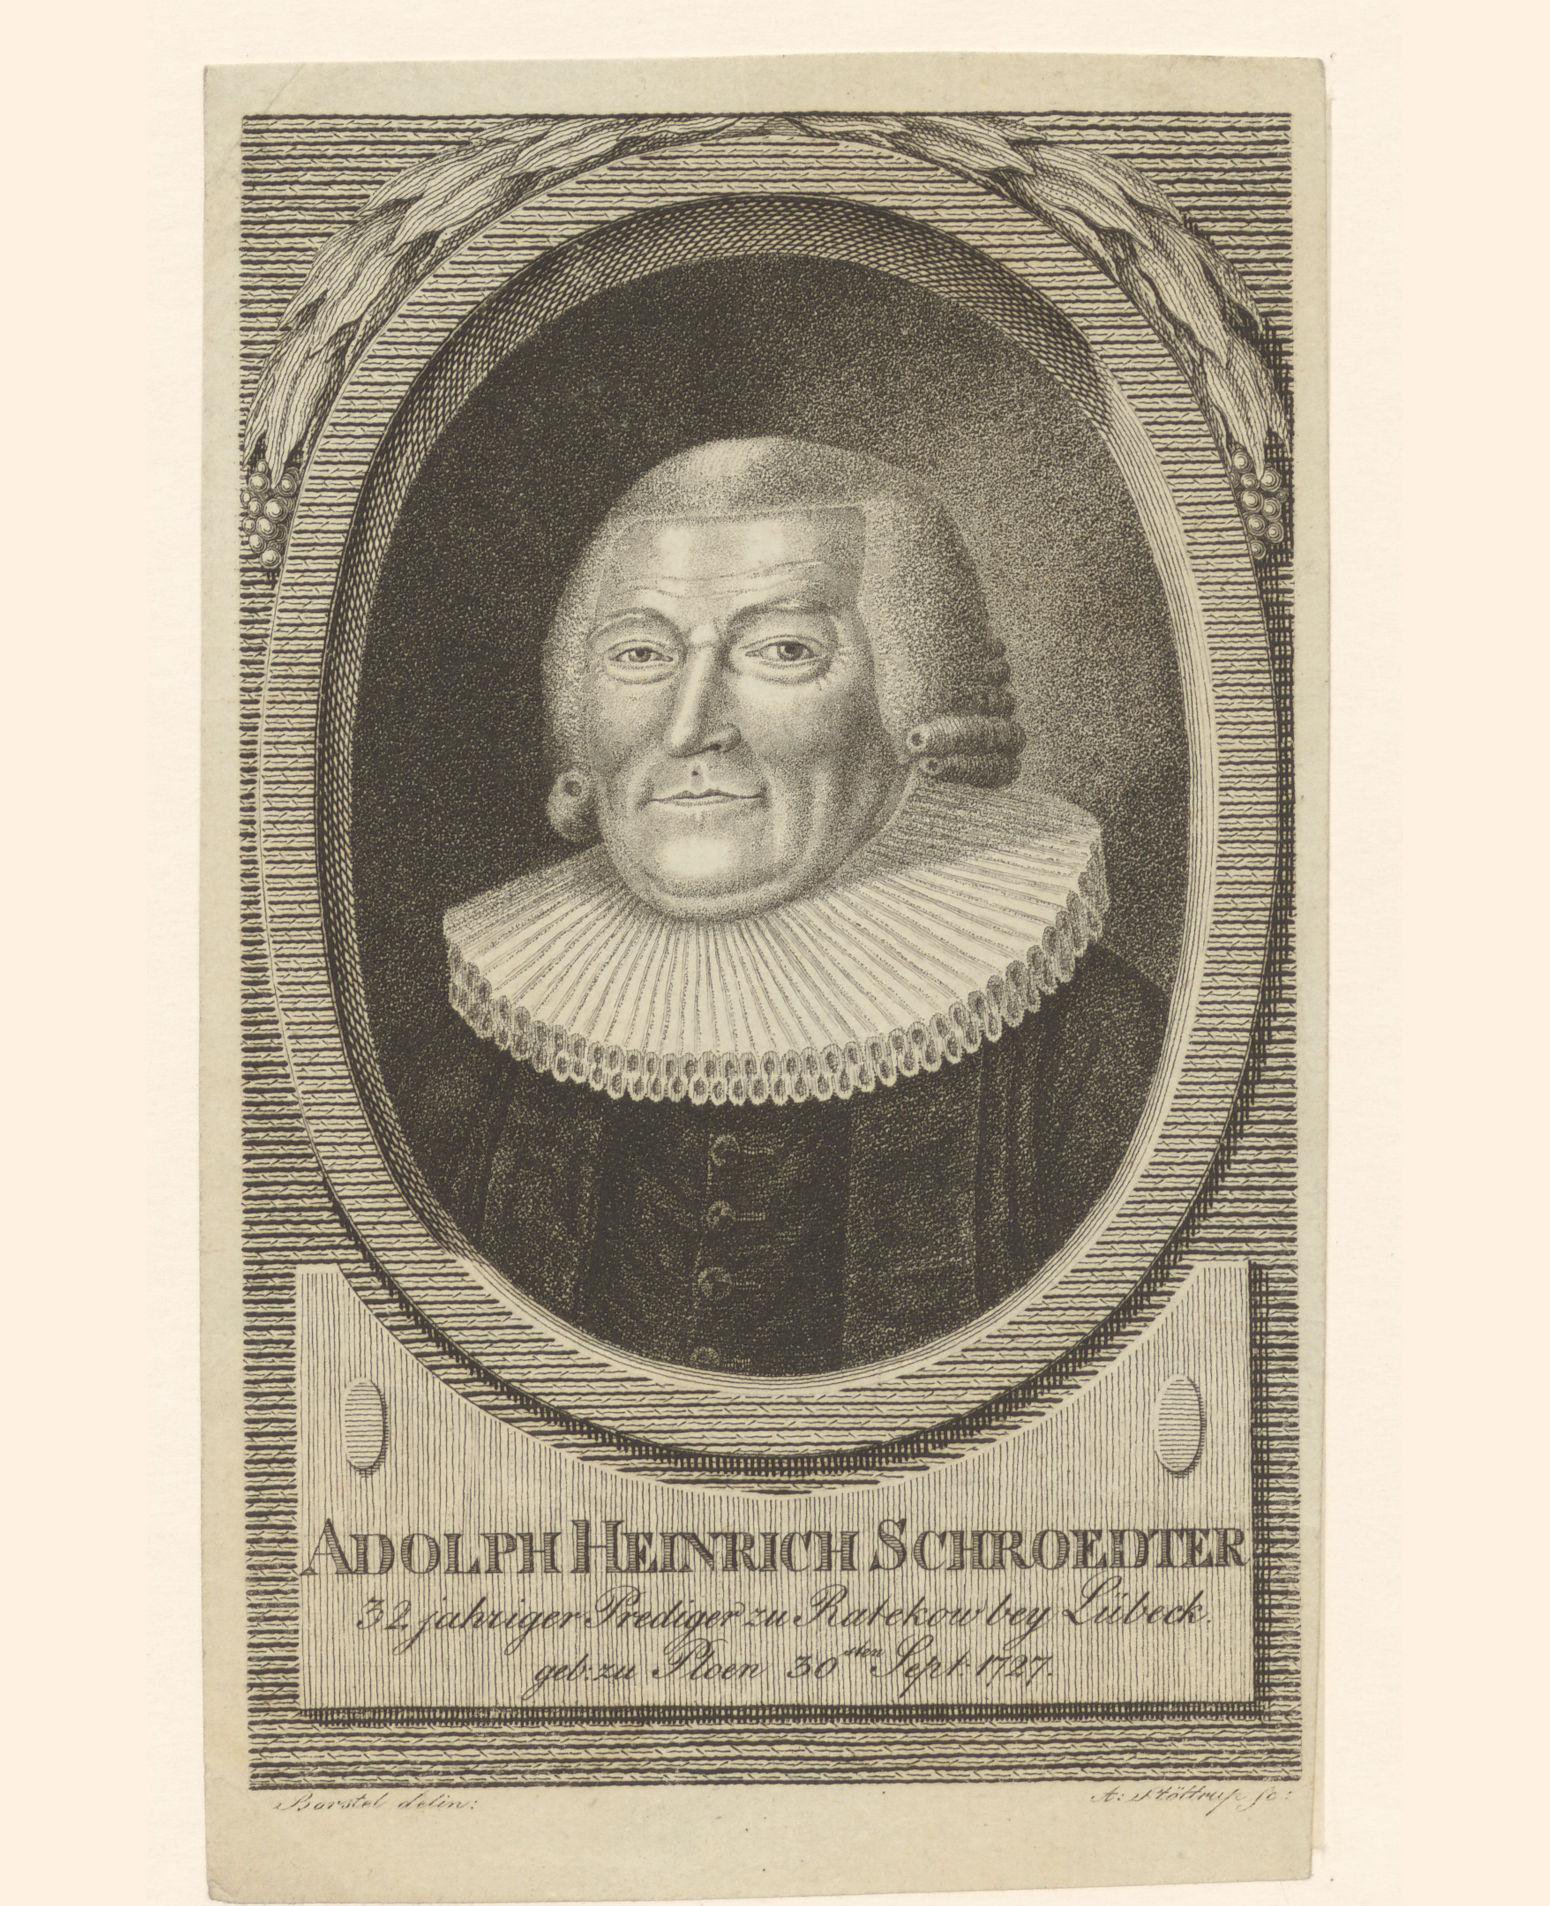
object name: print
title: Portret van Adolph Heinrich Schrödter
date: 1761-1812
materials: paper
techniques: engraving, etching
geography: hamburg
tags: historical persons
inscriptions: collector's mark: Lugt 2228